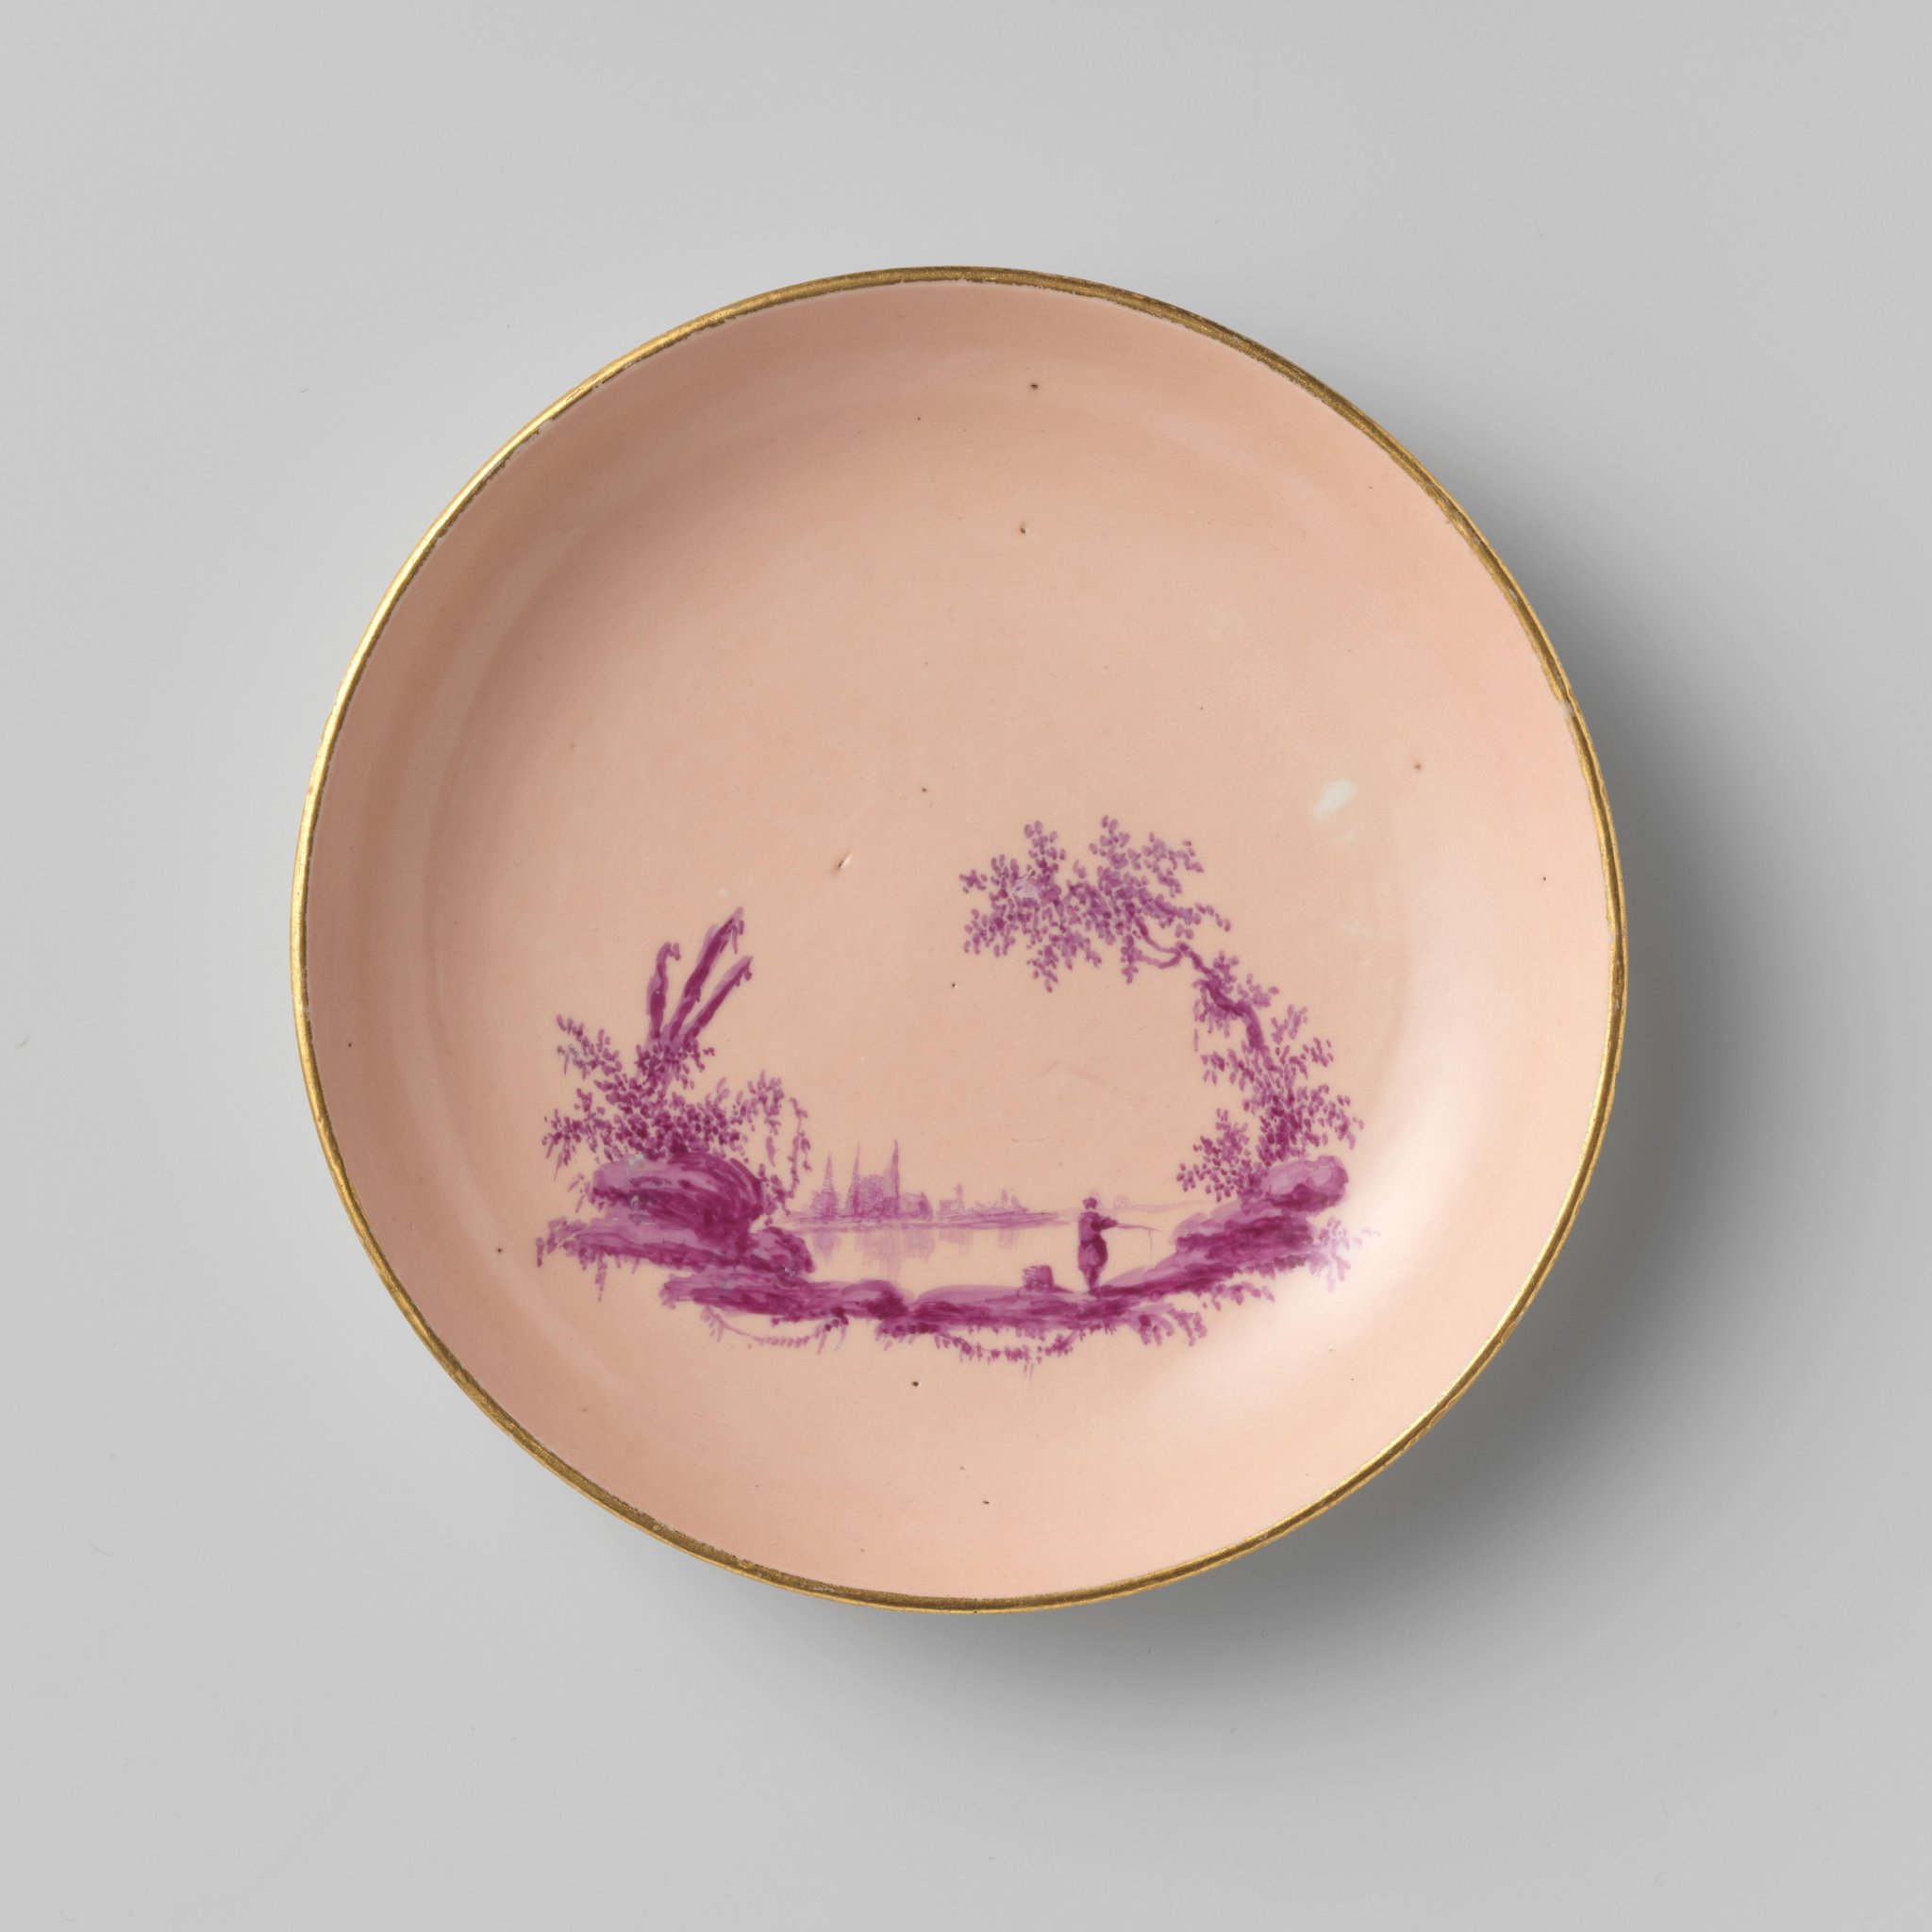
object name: platter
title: Schotel van een koffie- en theeservies, beschilderd met figuren in een rivierenlandschap in bietenrood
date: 1774-1778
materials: porcelain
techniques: painted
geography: loosdrecht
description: Parts of a tea and coffee service with pink ground. Porcelain. Loosdrecht, c. 1774 - 1776. Factory of Joannes de Mol.